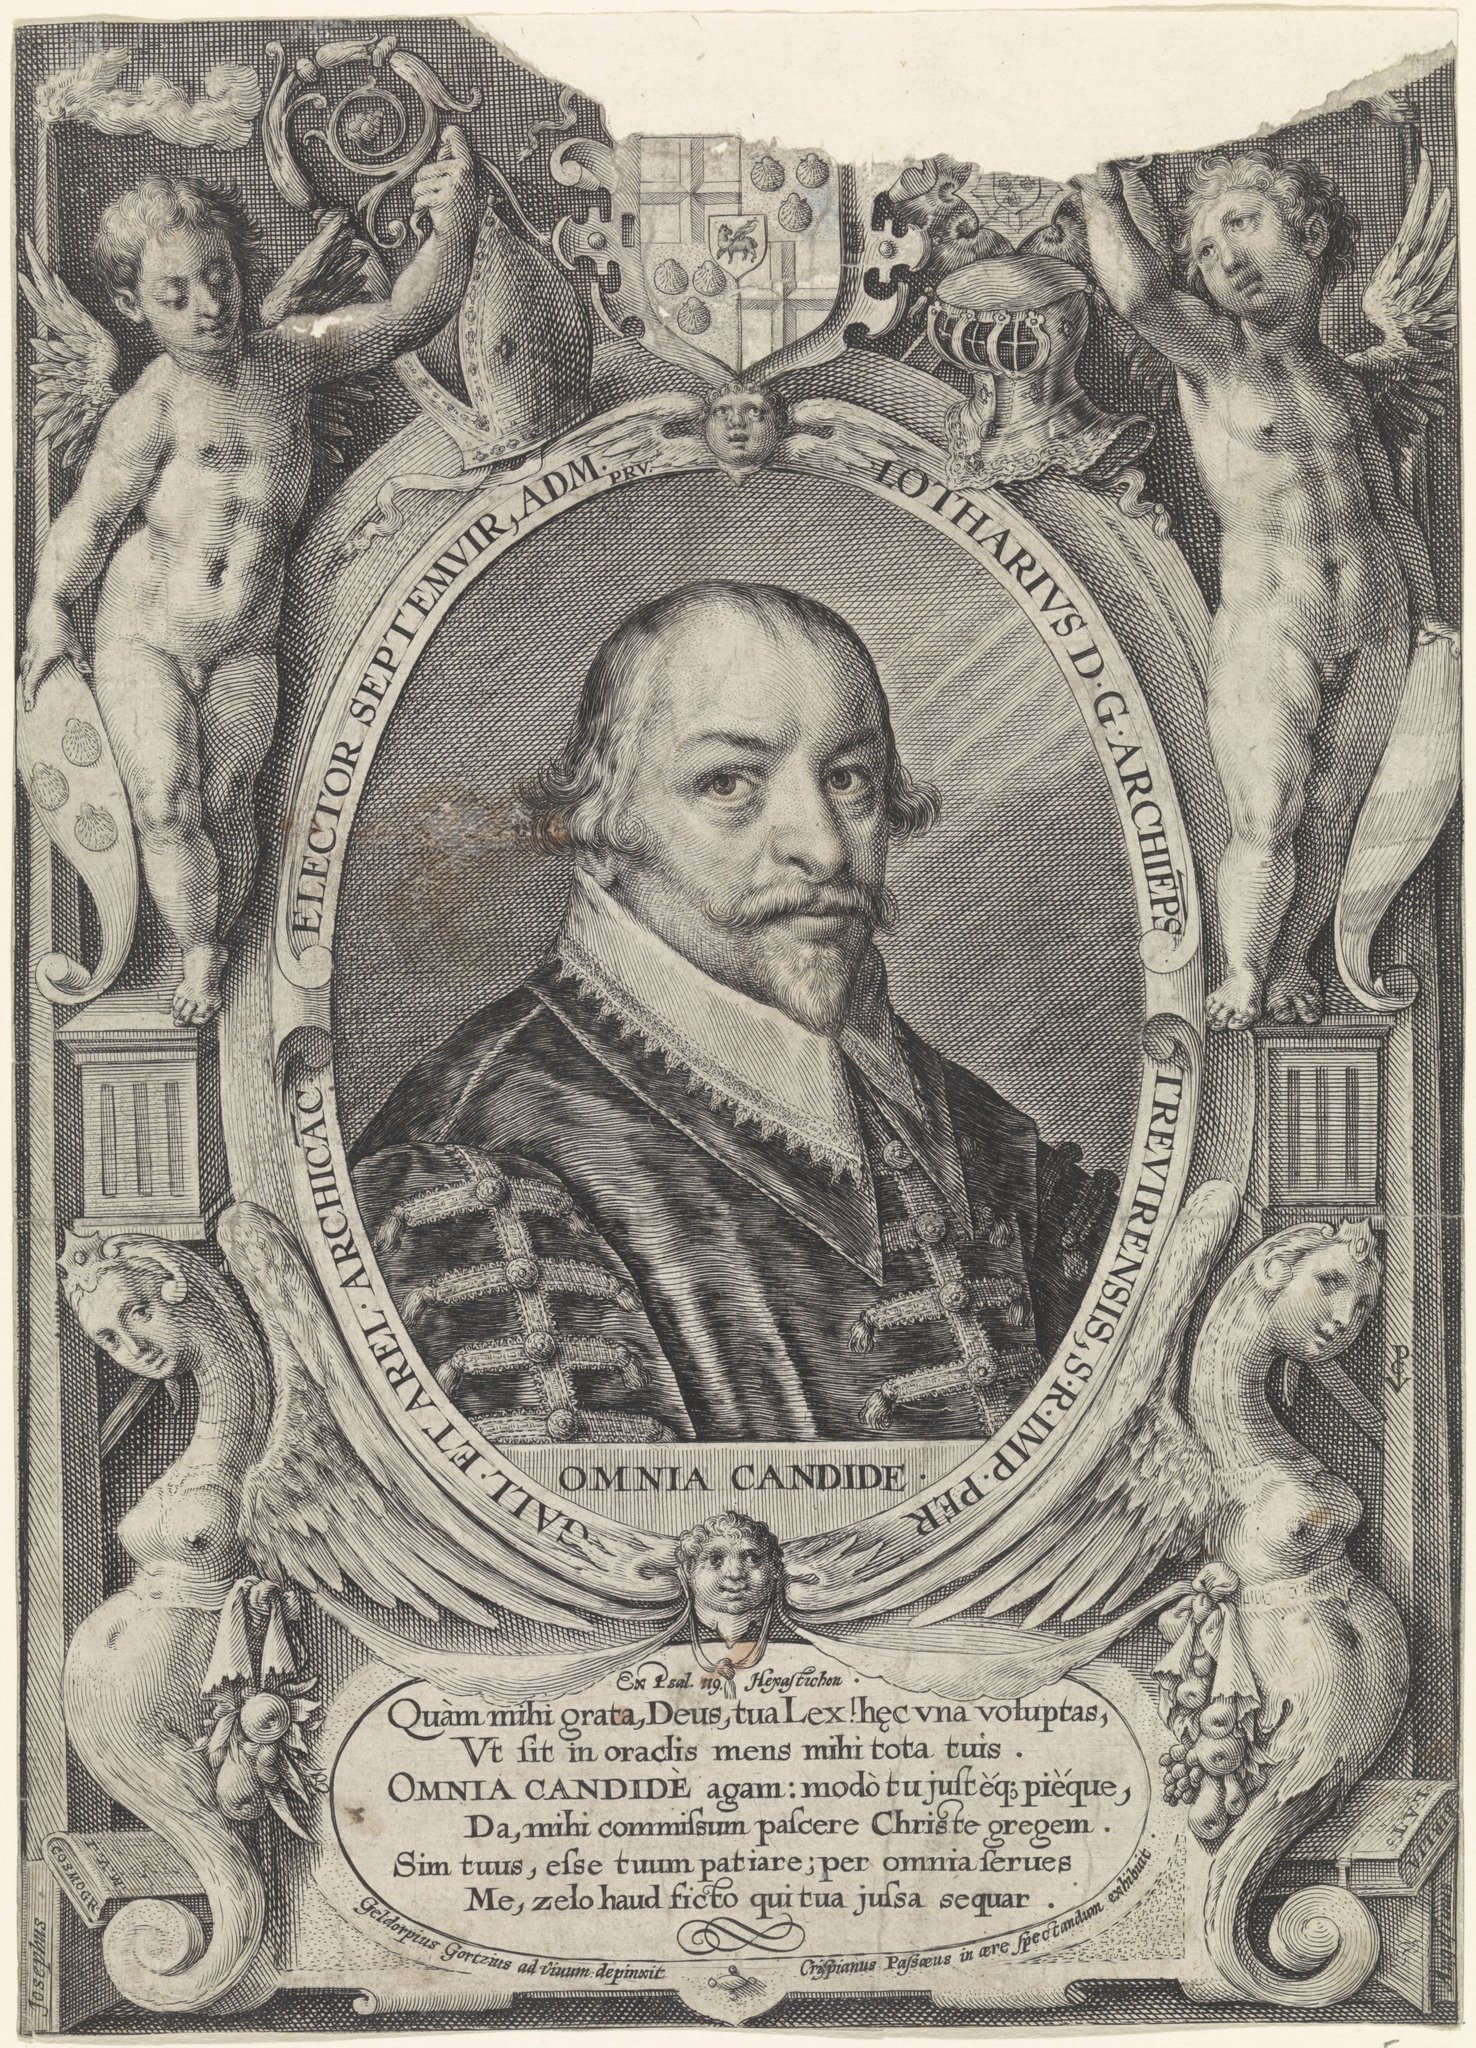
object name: print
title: Portret van Lothar van Metternich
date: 1574-1637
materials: paper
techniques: engraving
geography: cologne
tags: insignia of bishop, e.g. mitre, crozier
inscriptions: collector's mark: Lugt 2228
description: Portret van Lothar van Metternich, aartsbisschop van Trier, eronder zijn devies in het Latijn. Boven de omlijsting het wapenschild van de geportretteerde. In een cartouche onder het portret een zesregelig Bijbelcitaat uit Ps. 119 in het Latijn.